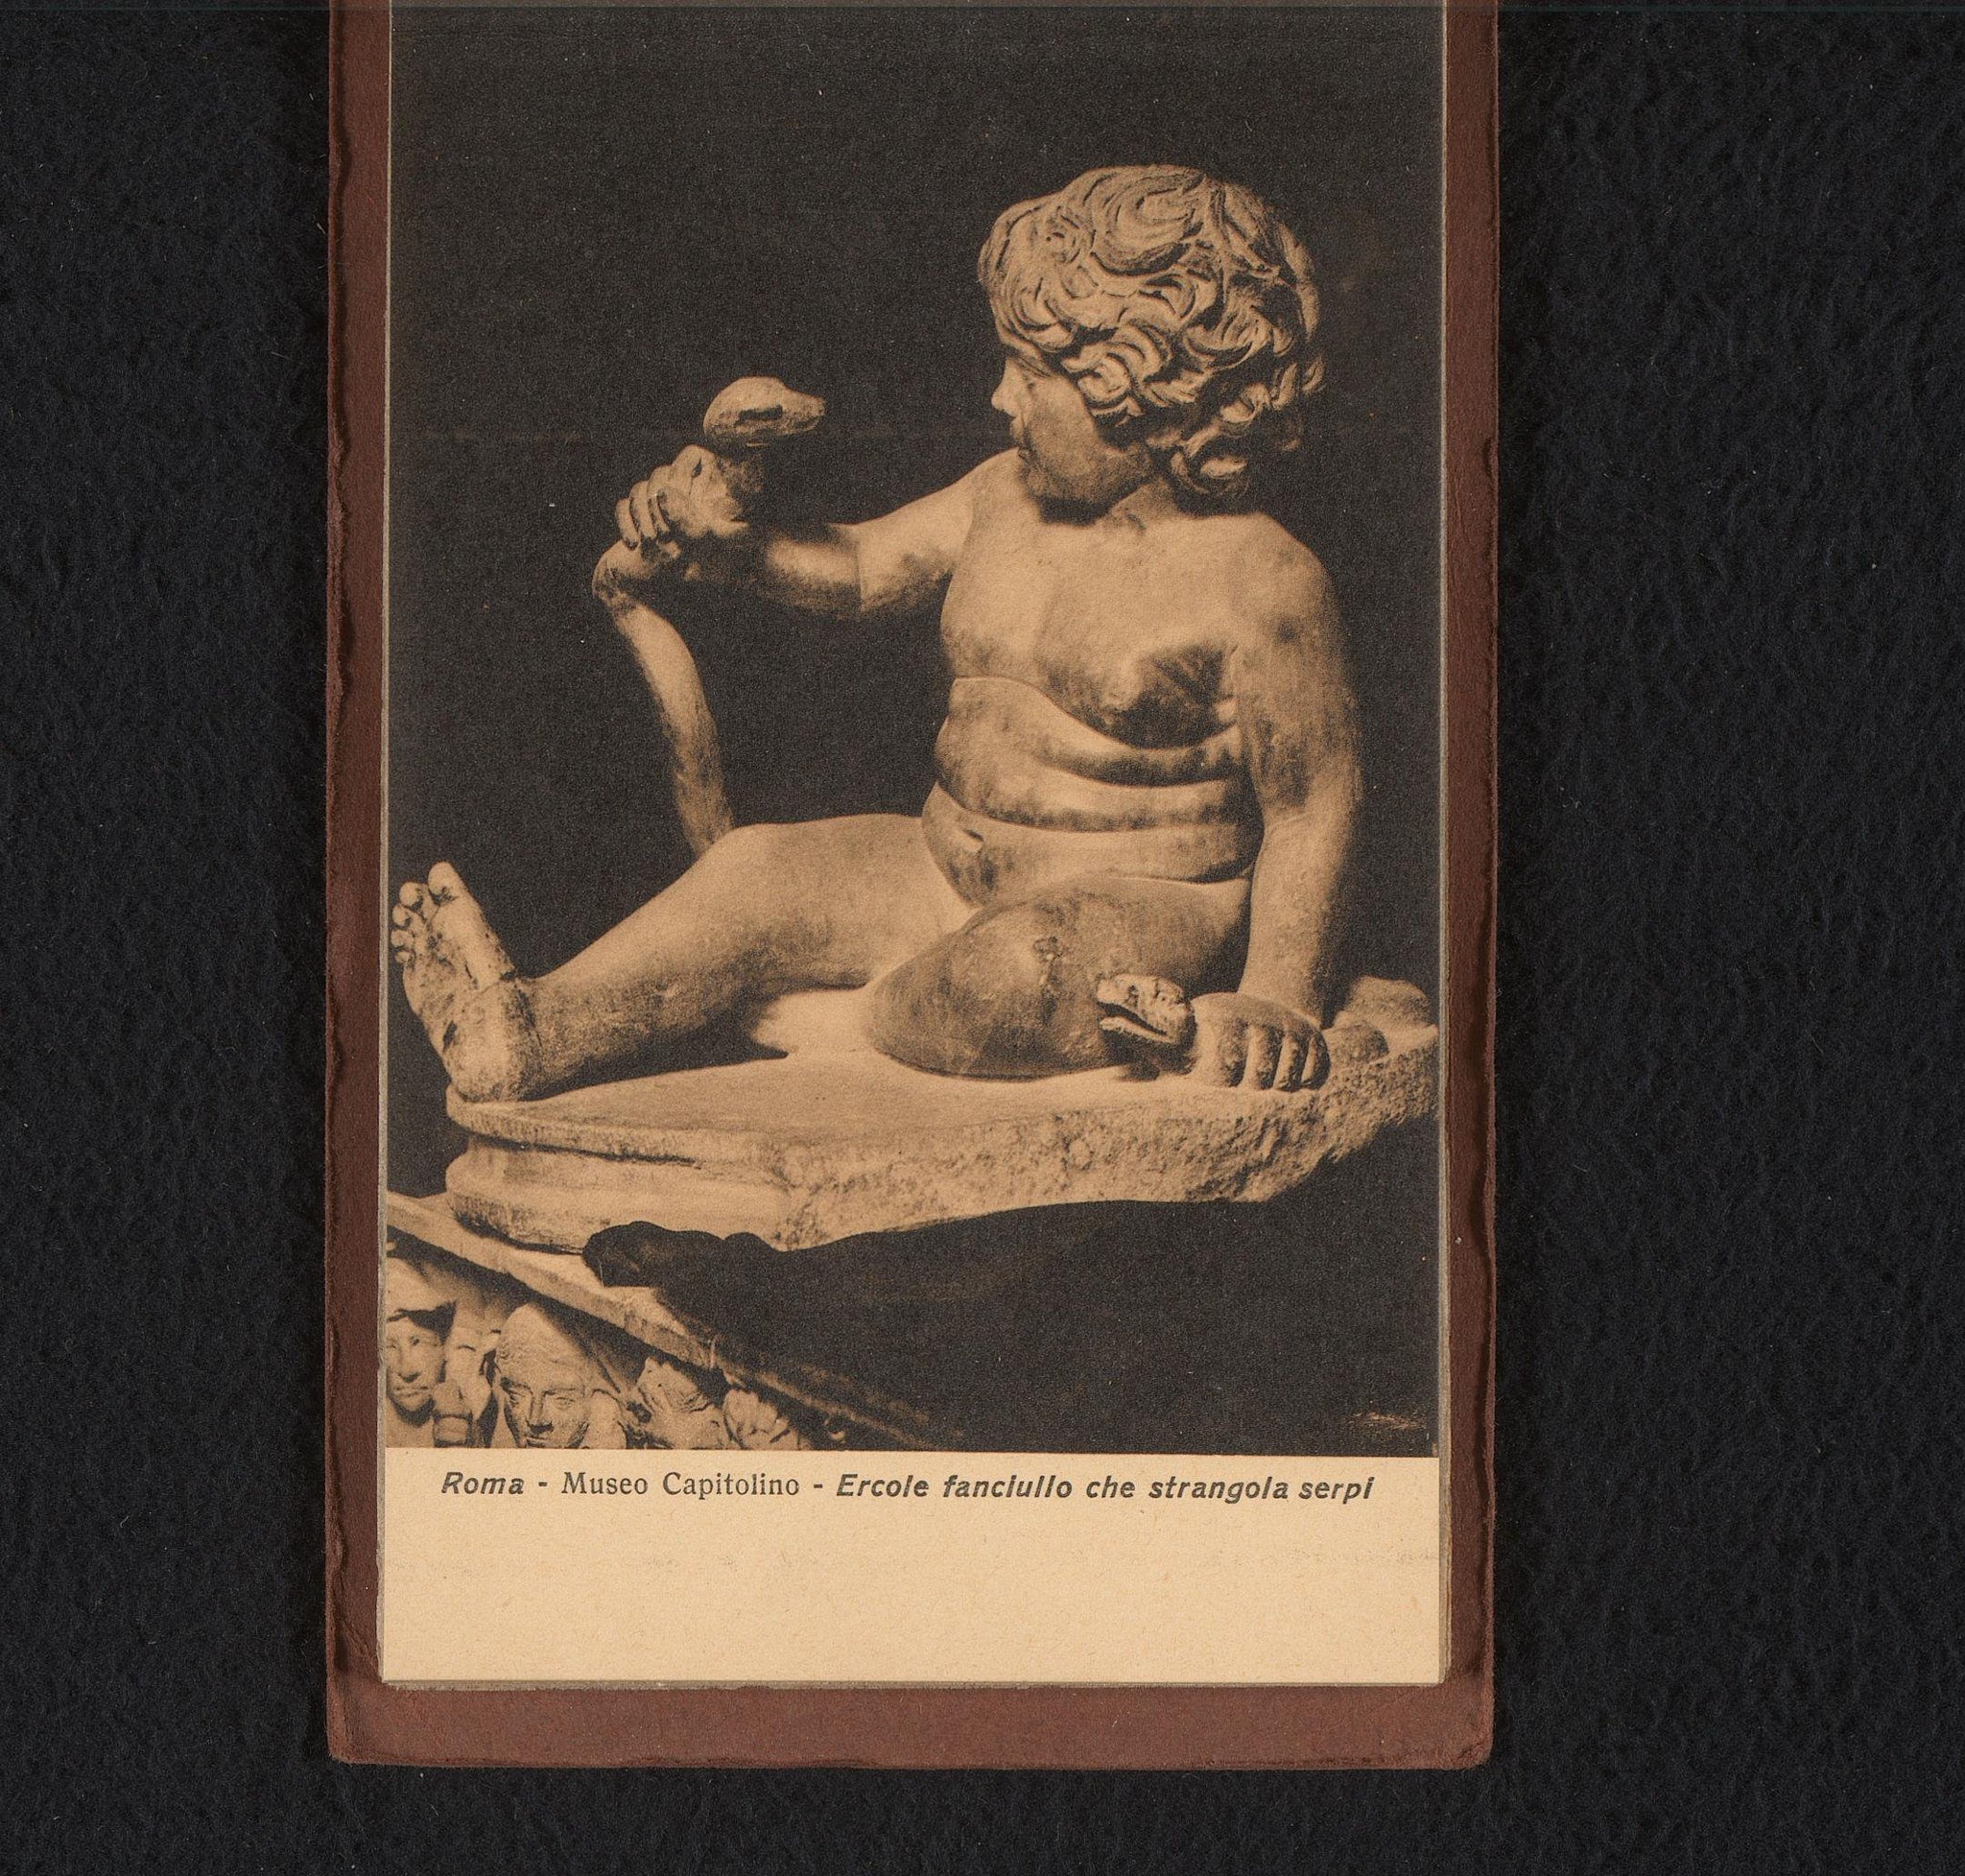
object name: photomechanical print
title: Roma - Museo Capitolino - Ercole fanciullo che strangola serpi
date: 1905-1930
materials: cardboard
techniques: photograph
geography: rome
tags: statues, paintings, etc. ~ objects of worship in roman religion, permanent exhibition, museum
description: Prentbriefkaart maakt deel uit van een album.